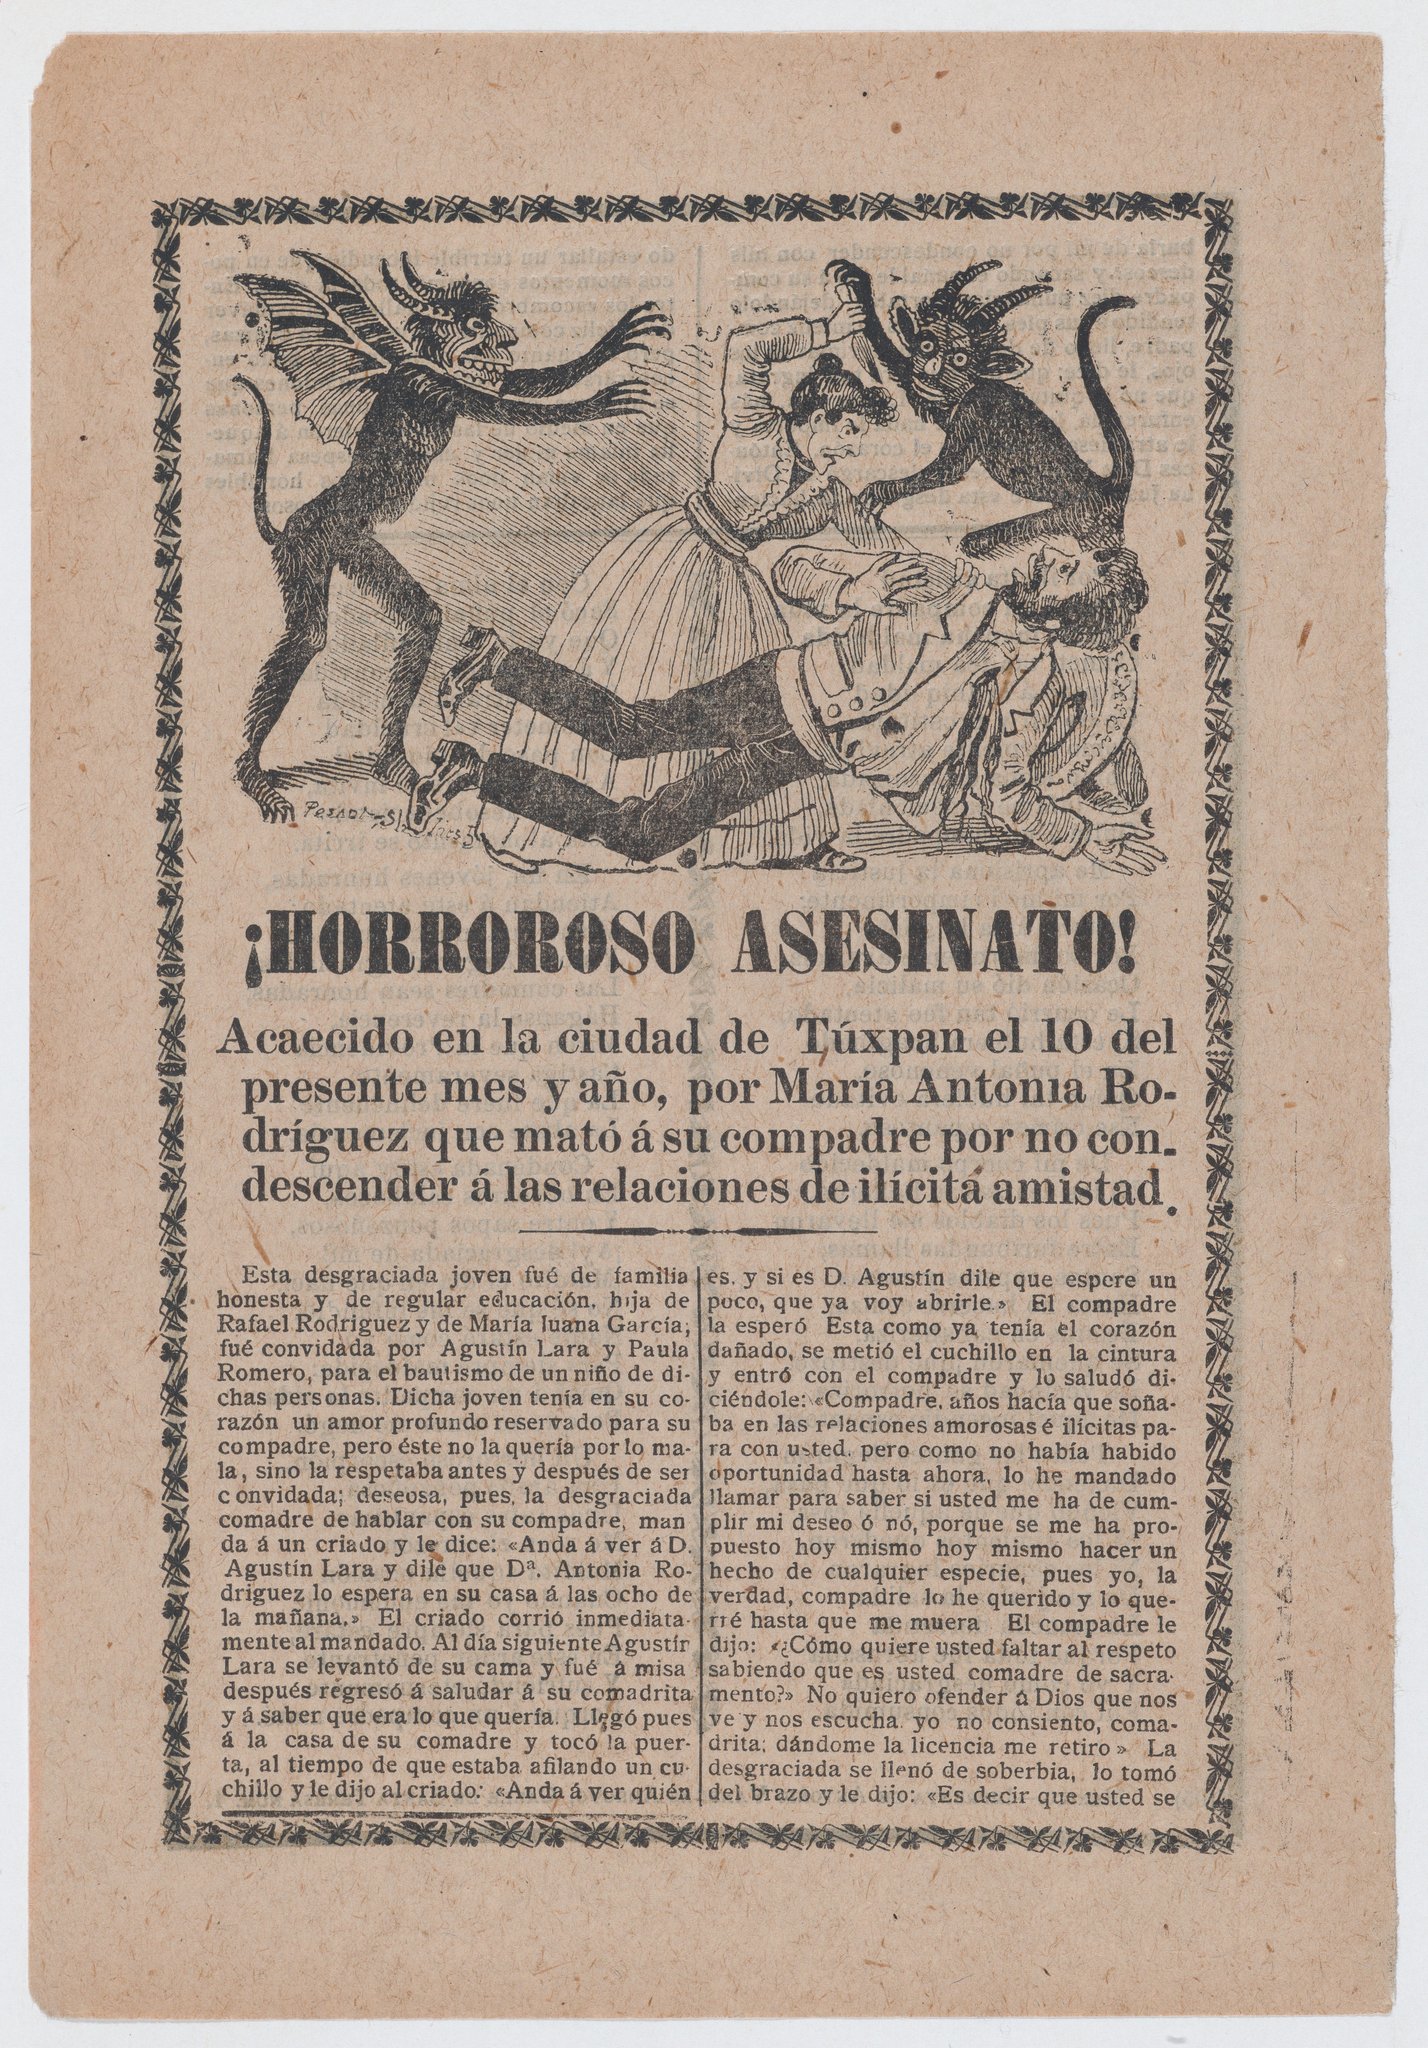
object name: print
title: Broadsheet relating to the execution of Florencio Morales and Bernardo Mora who assassinated ex-President Barillas of Guatemala, a description in the bottom section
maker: josé guadalupe posada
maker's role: artist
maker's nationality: mexican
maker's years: 1852-1913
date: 1902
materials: paper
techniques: letterpress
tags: men,women,devil,execution,documents